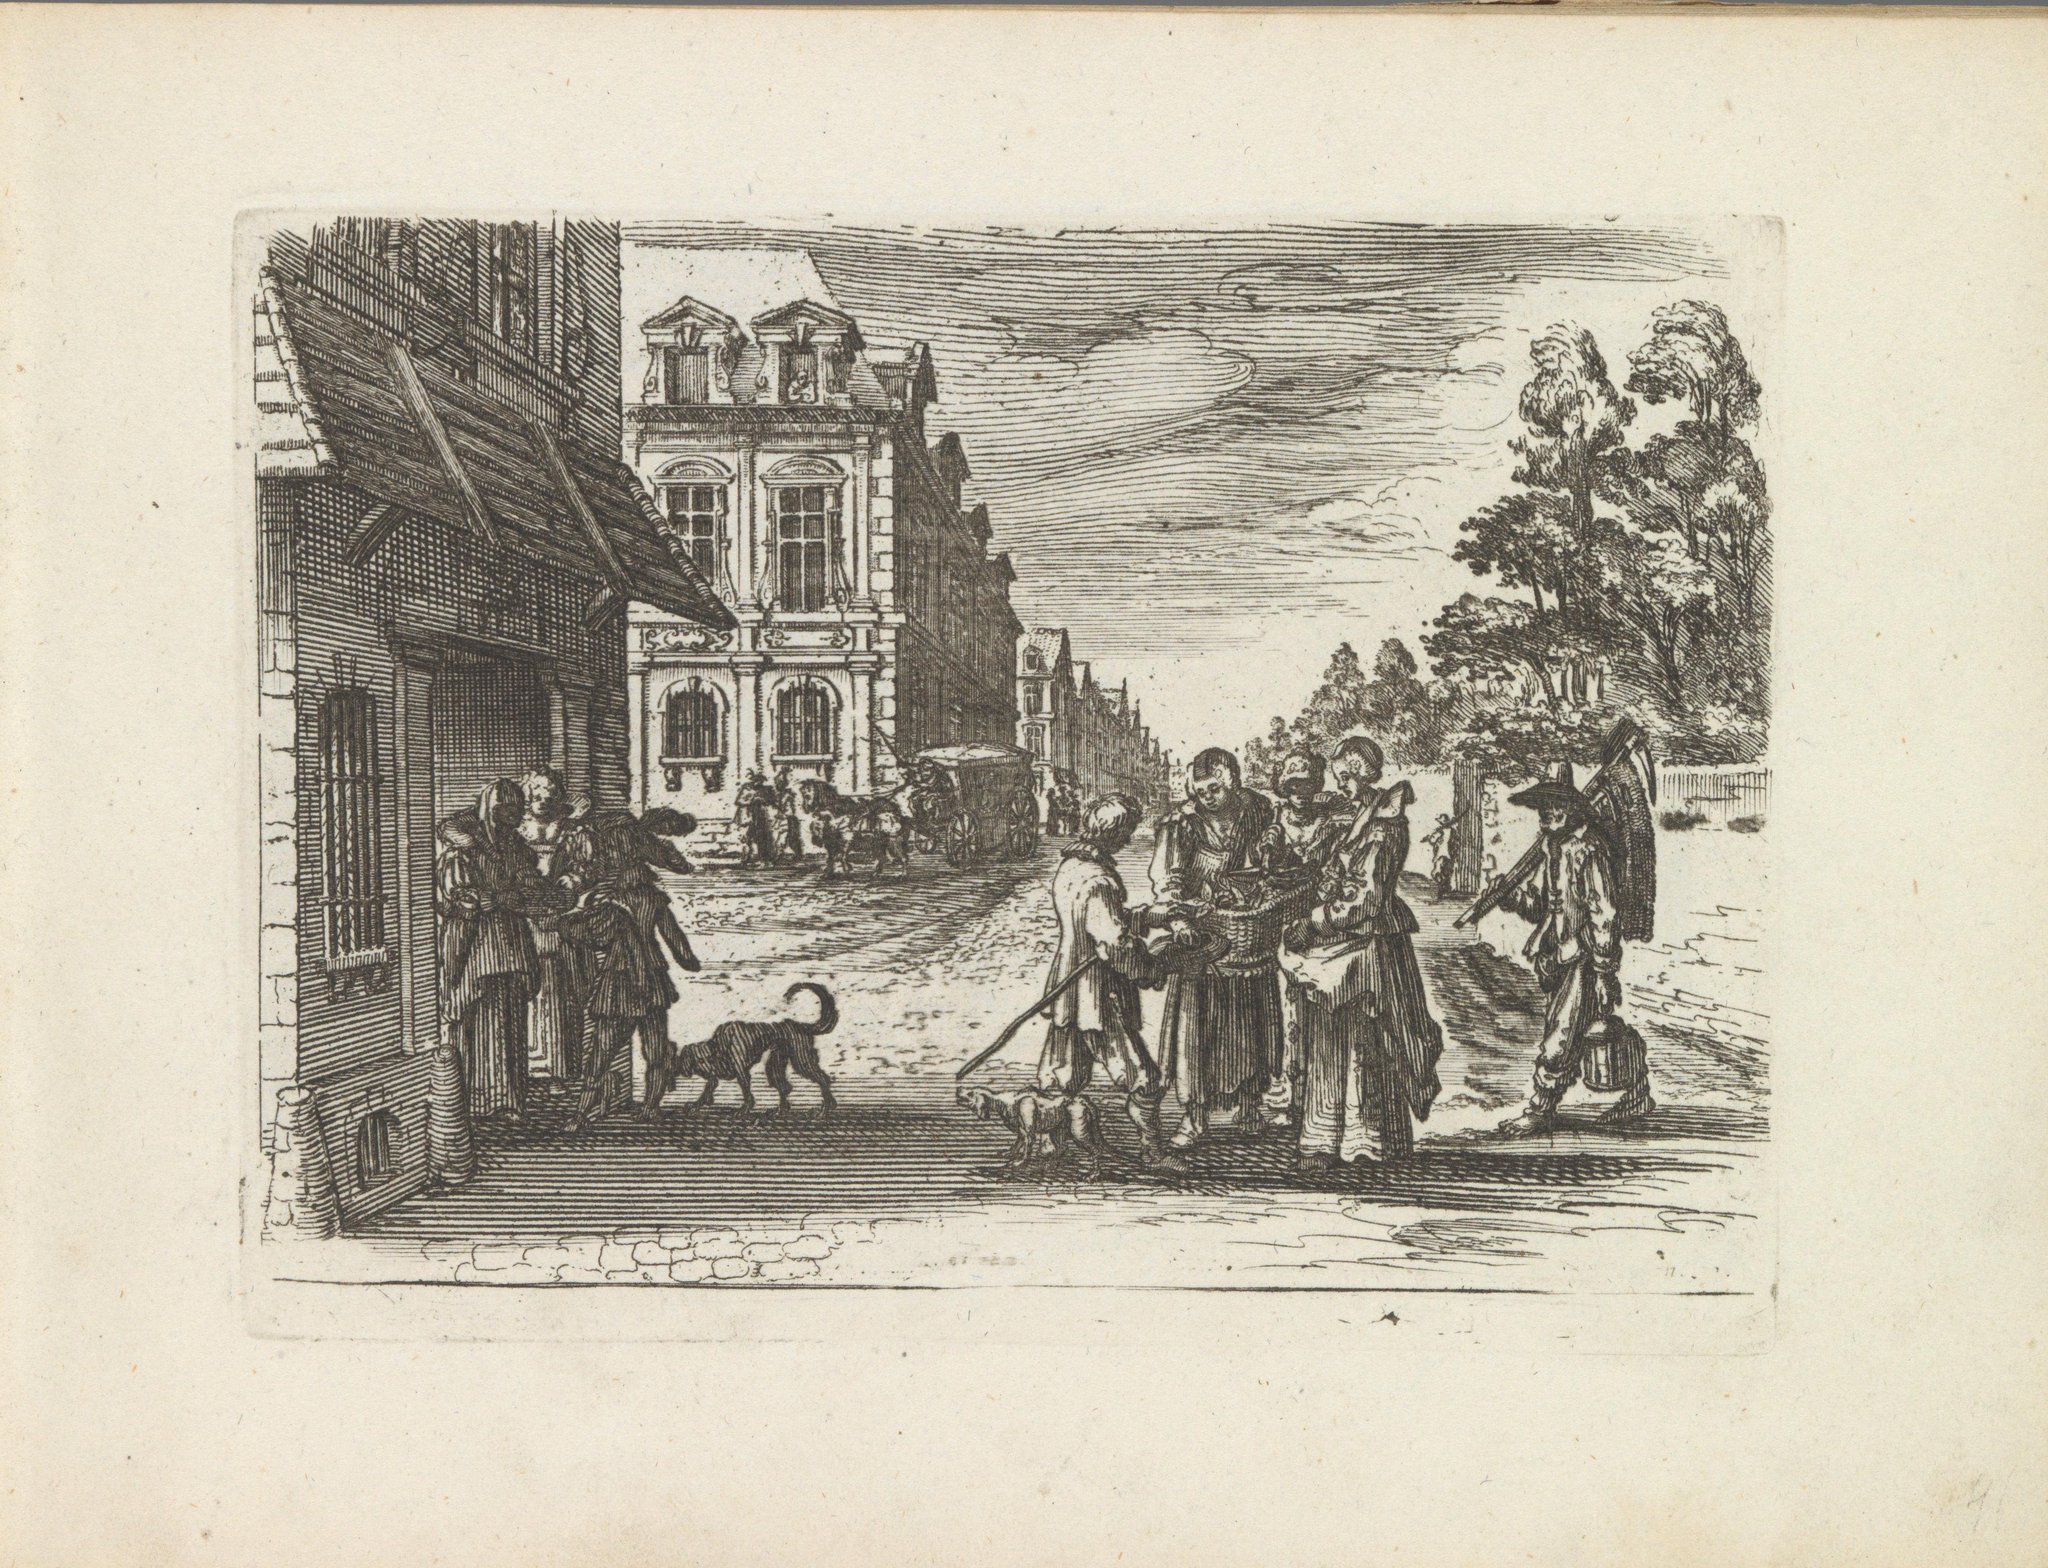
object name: album leaf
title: Spiegel der natuur en school der teekenkunde (...)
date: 1600-1699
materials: paper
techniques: etching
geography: amsterdam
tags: urban housing, street-trader - bb - women engaged in trade and commerce, passenger carriage, dog, street (+ city(-scape) with figures, staffage)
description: Gezicht op een straat in een stad met links huizen. Door de straat rijdt een koets met twee paarden. Op de voorgrond een koopvrouw. Twee dames en een man bekijken de koopwaar. Links staat een man bij twee dames aan de deur. Twee honden blaffen tegen elkaar. De prent maakt deel uit van een album.